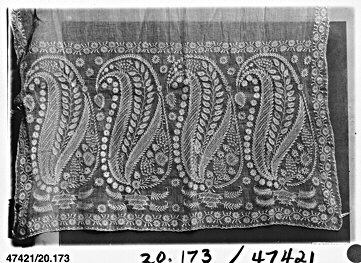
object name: shawl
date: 1801-1900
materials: cotton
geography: bangladesh